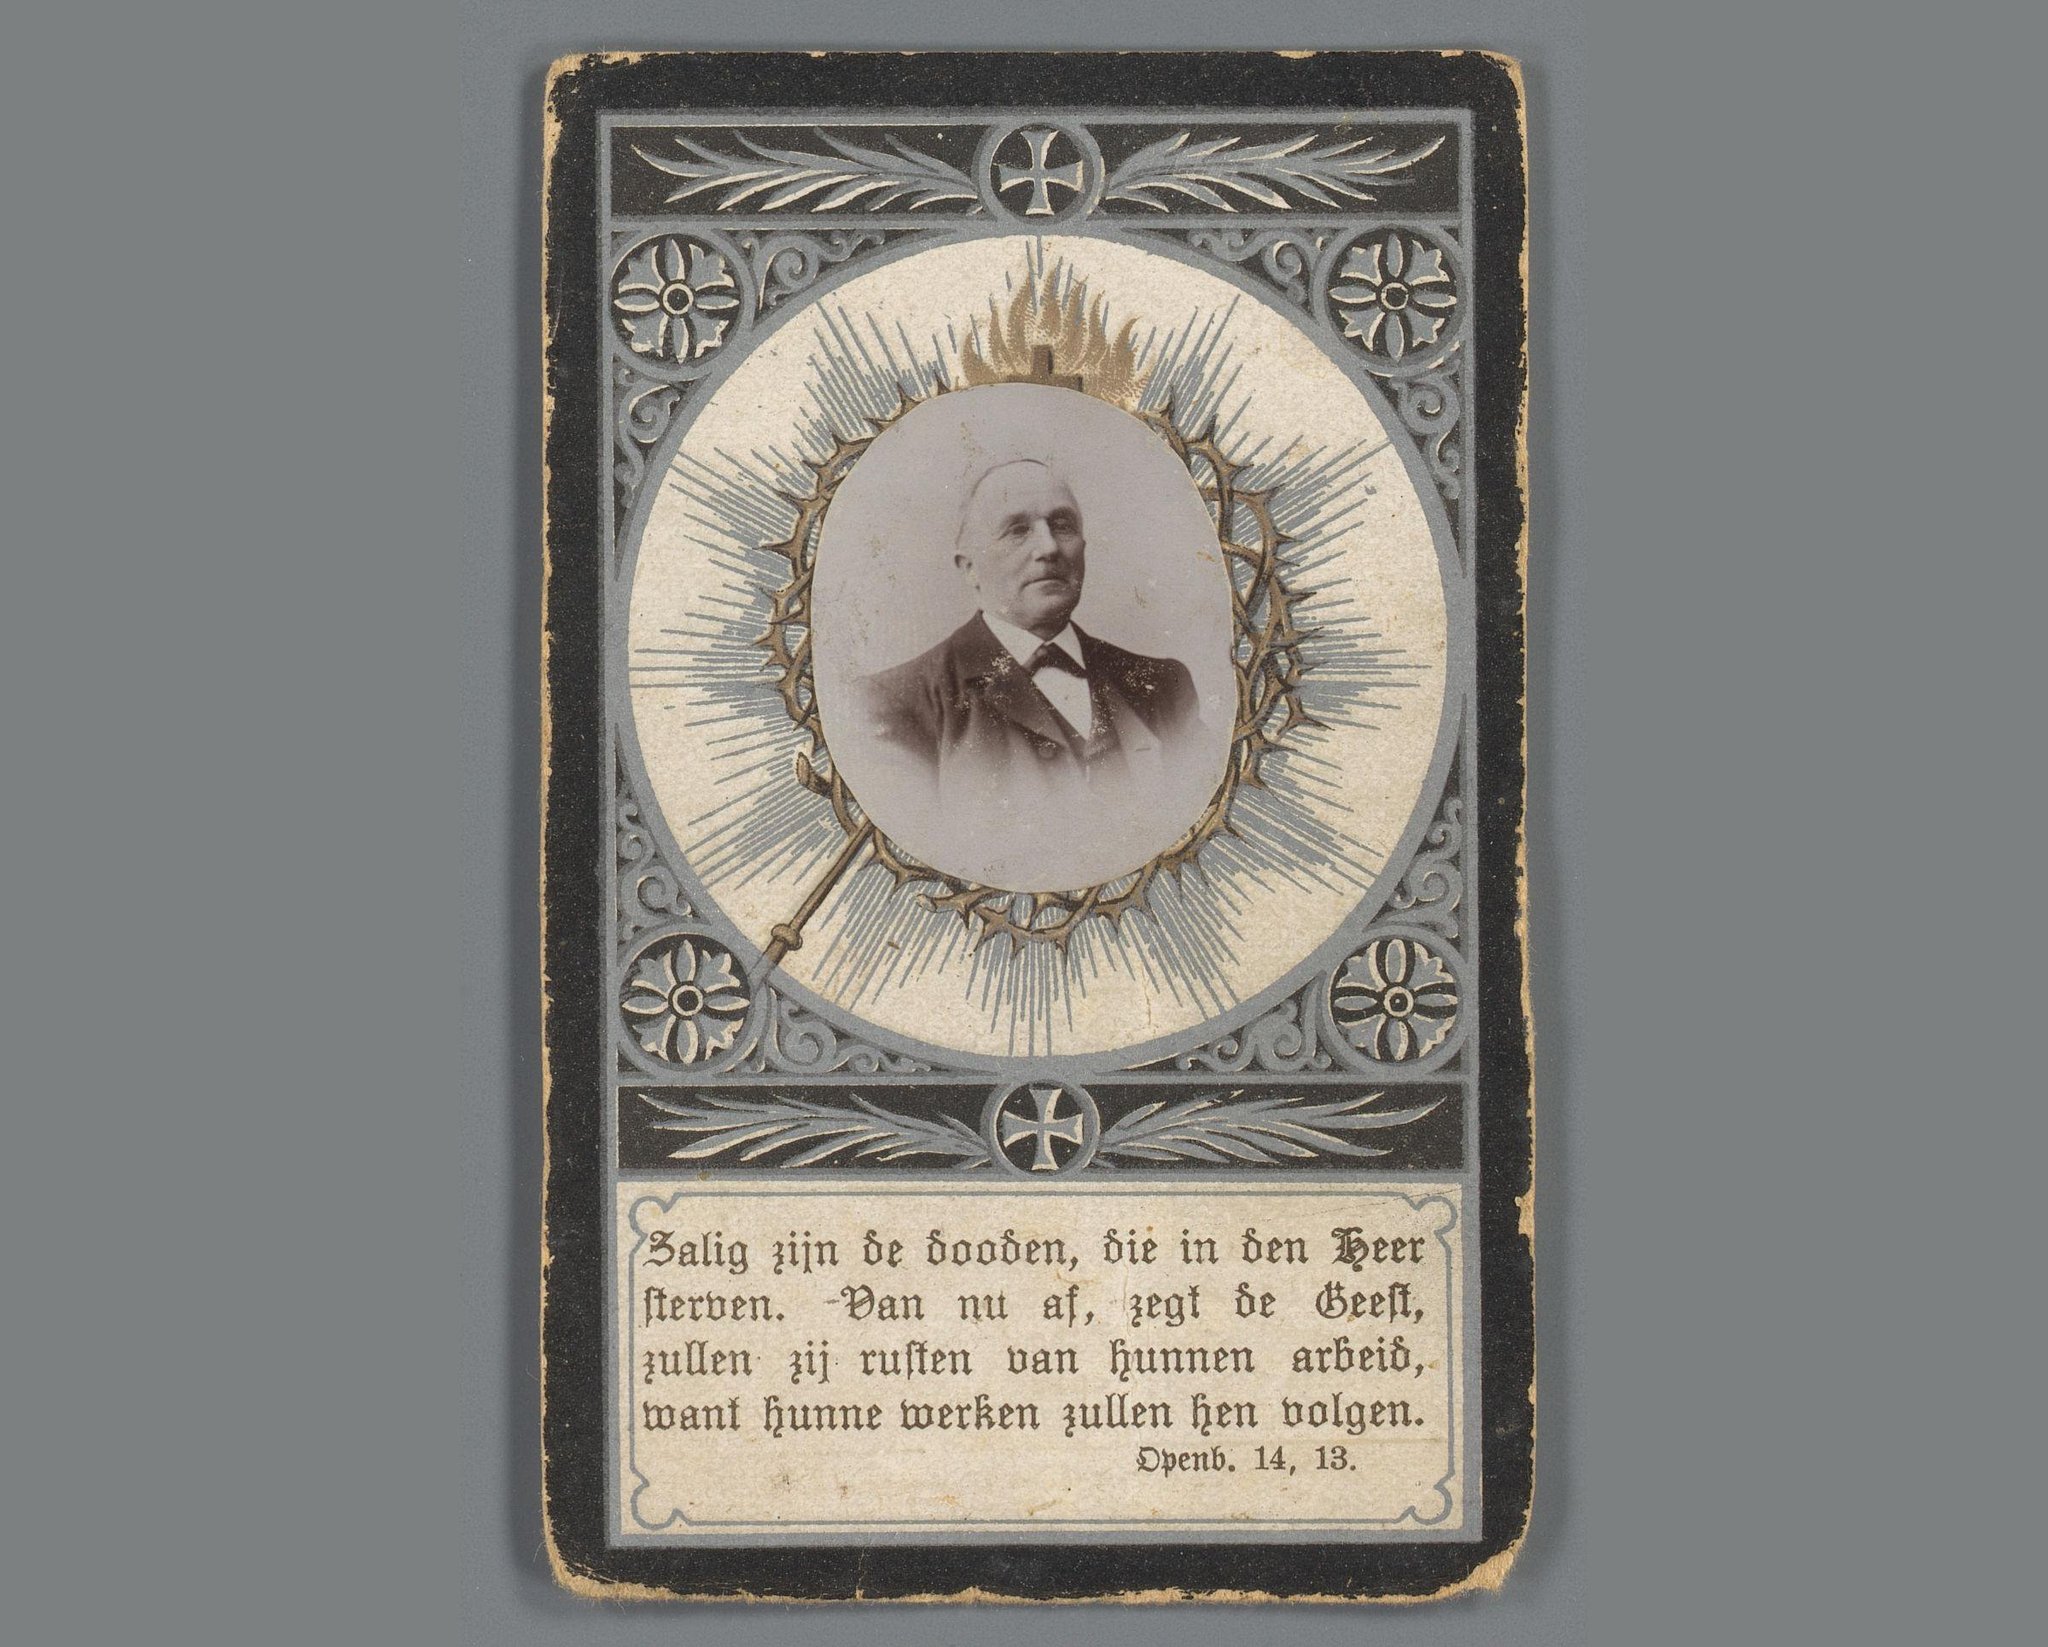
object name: photograph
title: Portret van Henricus Theodorus van Zanten op bidprent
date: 1908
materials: paper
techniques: lithograph, letterpress printing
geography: berkel en rodenrijs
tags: adult man, historical persons, crown of thorns ~ instruments of the passion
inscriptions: inscription: ‘Zalig zijn de dooden, (...) Openb. 14, 13.’, inscription: ‘Bid voor de ziel van zaliger (...) Jezus Christus onzen Heer. Amen./ Toussaint - Berkel.’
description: Op de bidprent staat een Bijbeltekst uit de Openbaringen met daarboven een stralende doornenkroon en een brandend hart waar het portret van de overledene in is opgenomen.